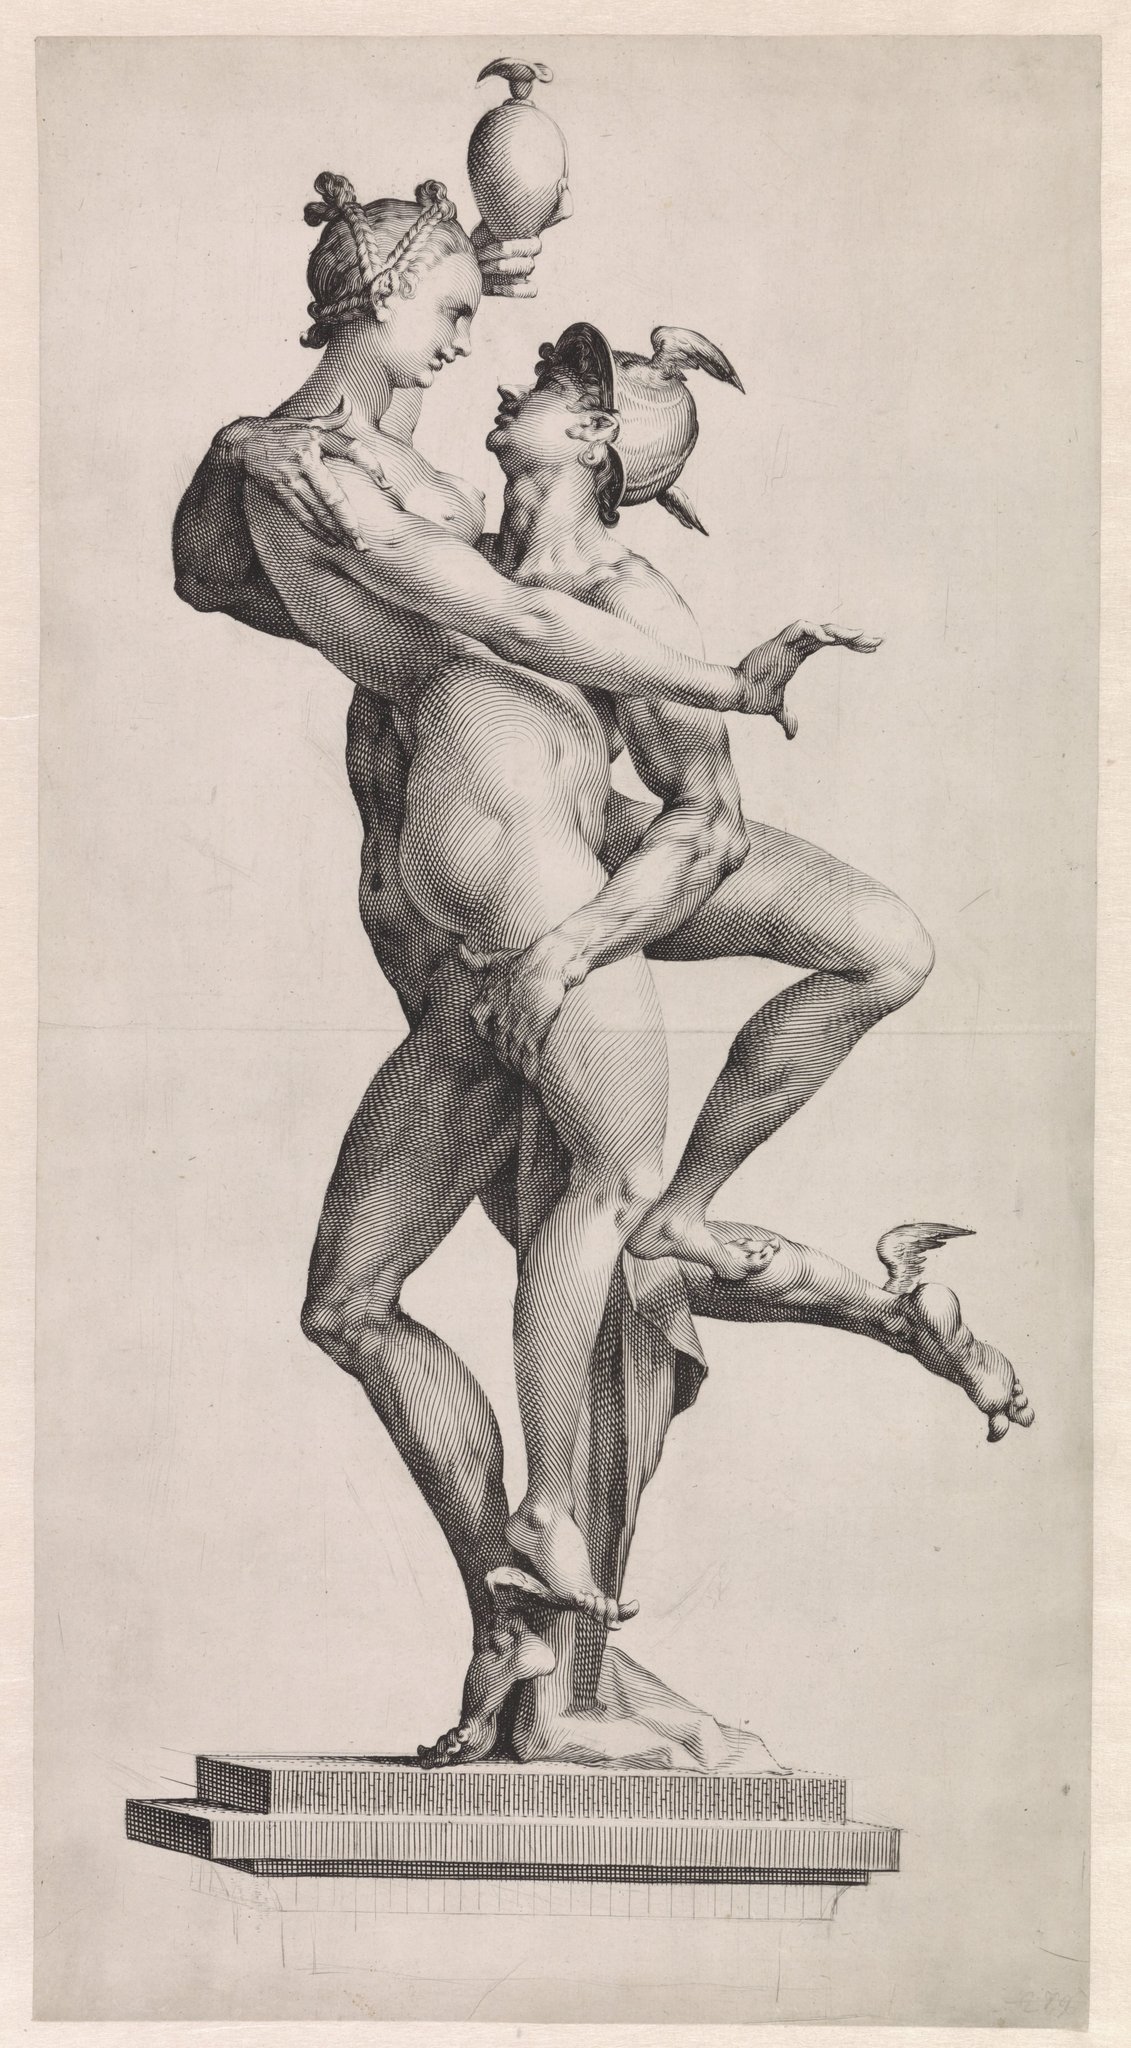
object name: print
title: Mercurius en Psyche: zijaanzicht met de zijde van Psyche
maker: jan harmensz. muller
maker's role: draughtsman, print maker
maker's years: 1571-1628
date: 1595-1599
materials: paper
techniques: engraving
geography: amsterdam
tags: psyche is carried up to olympus by mercury, (story of) mercury (hermes), piece of sculpture, reproduction of a piece of sculpture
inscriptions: collector's mark: Lugt 240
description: Mercurius draagt Psyche naar de hemel. Naar een sculptuur van beeldhouwer Adriaen de Vries. Zijaanzicht met de zijde van Psyche.